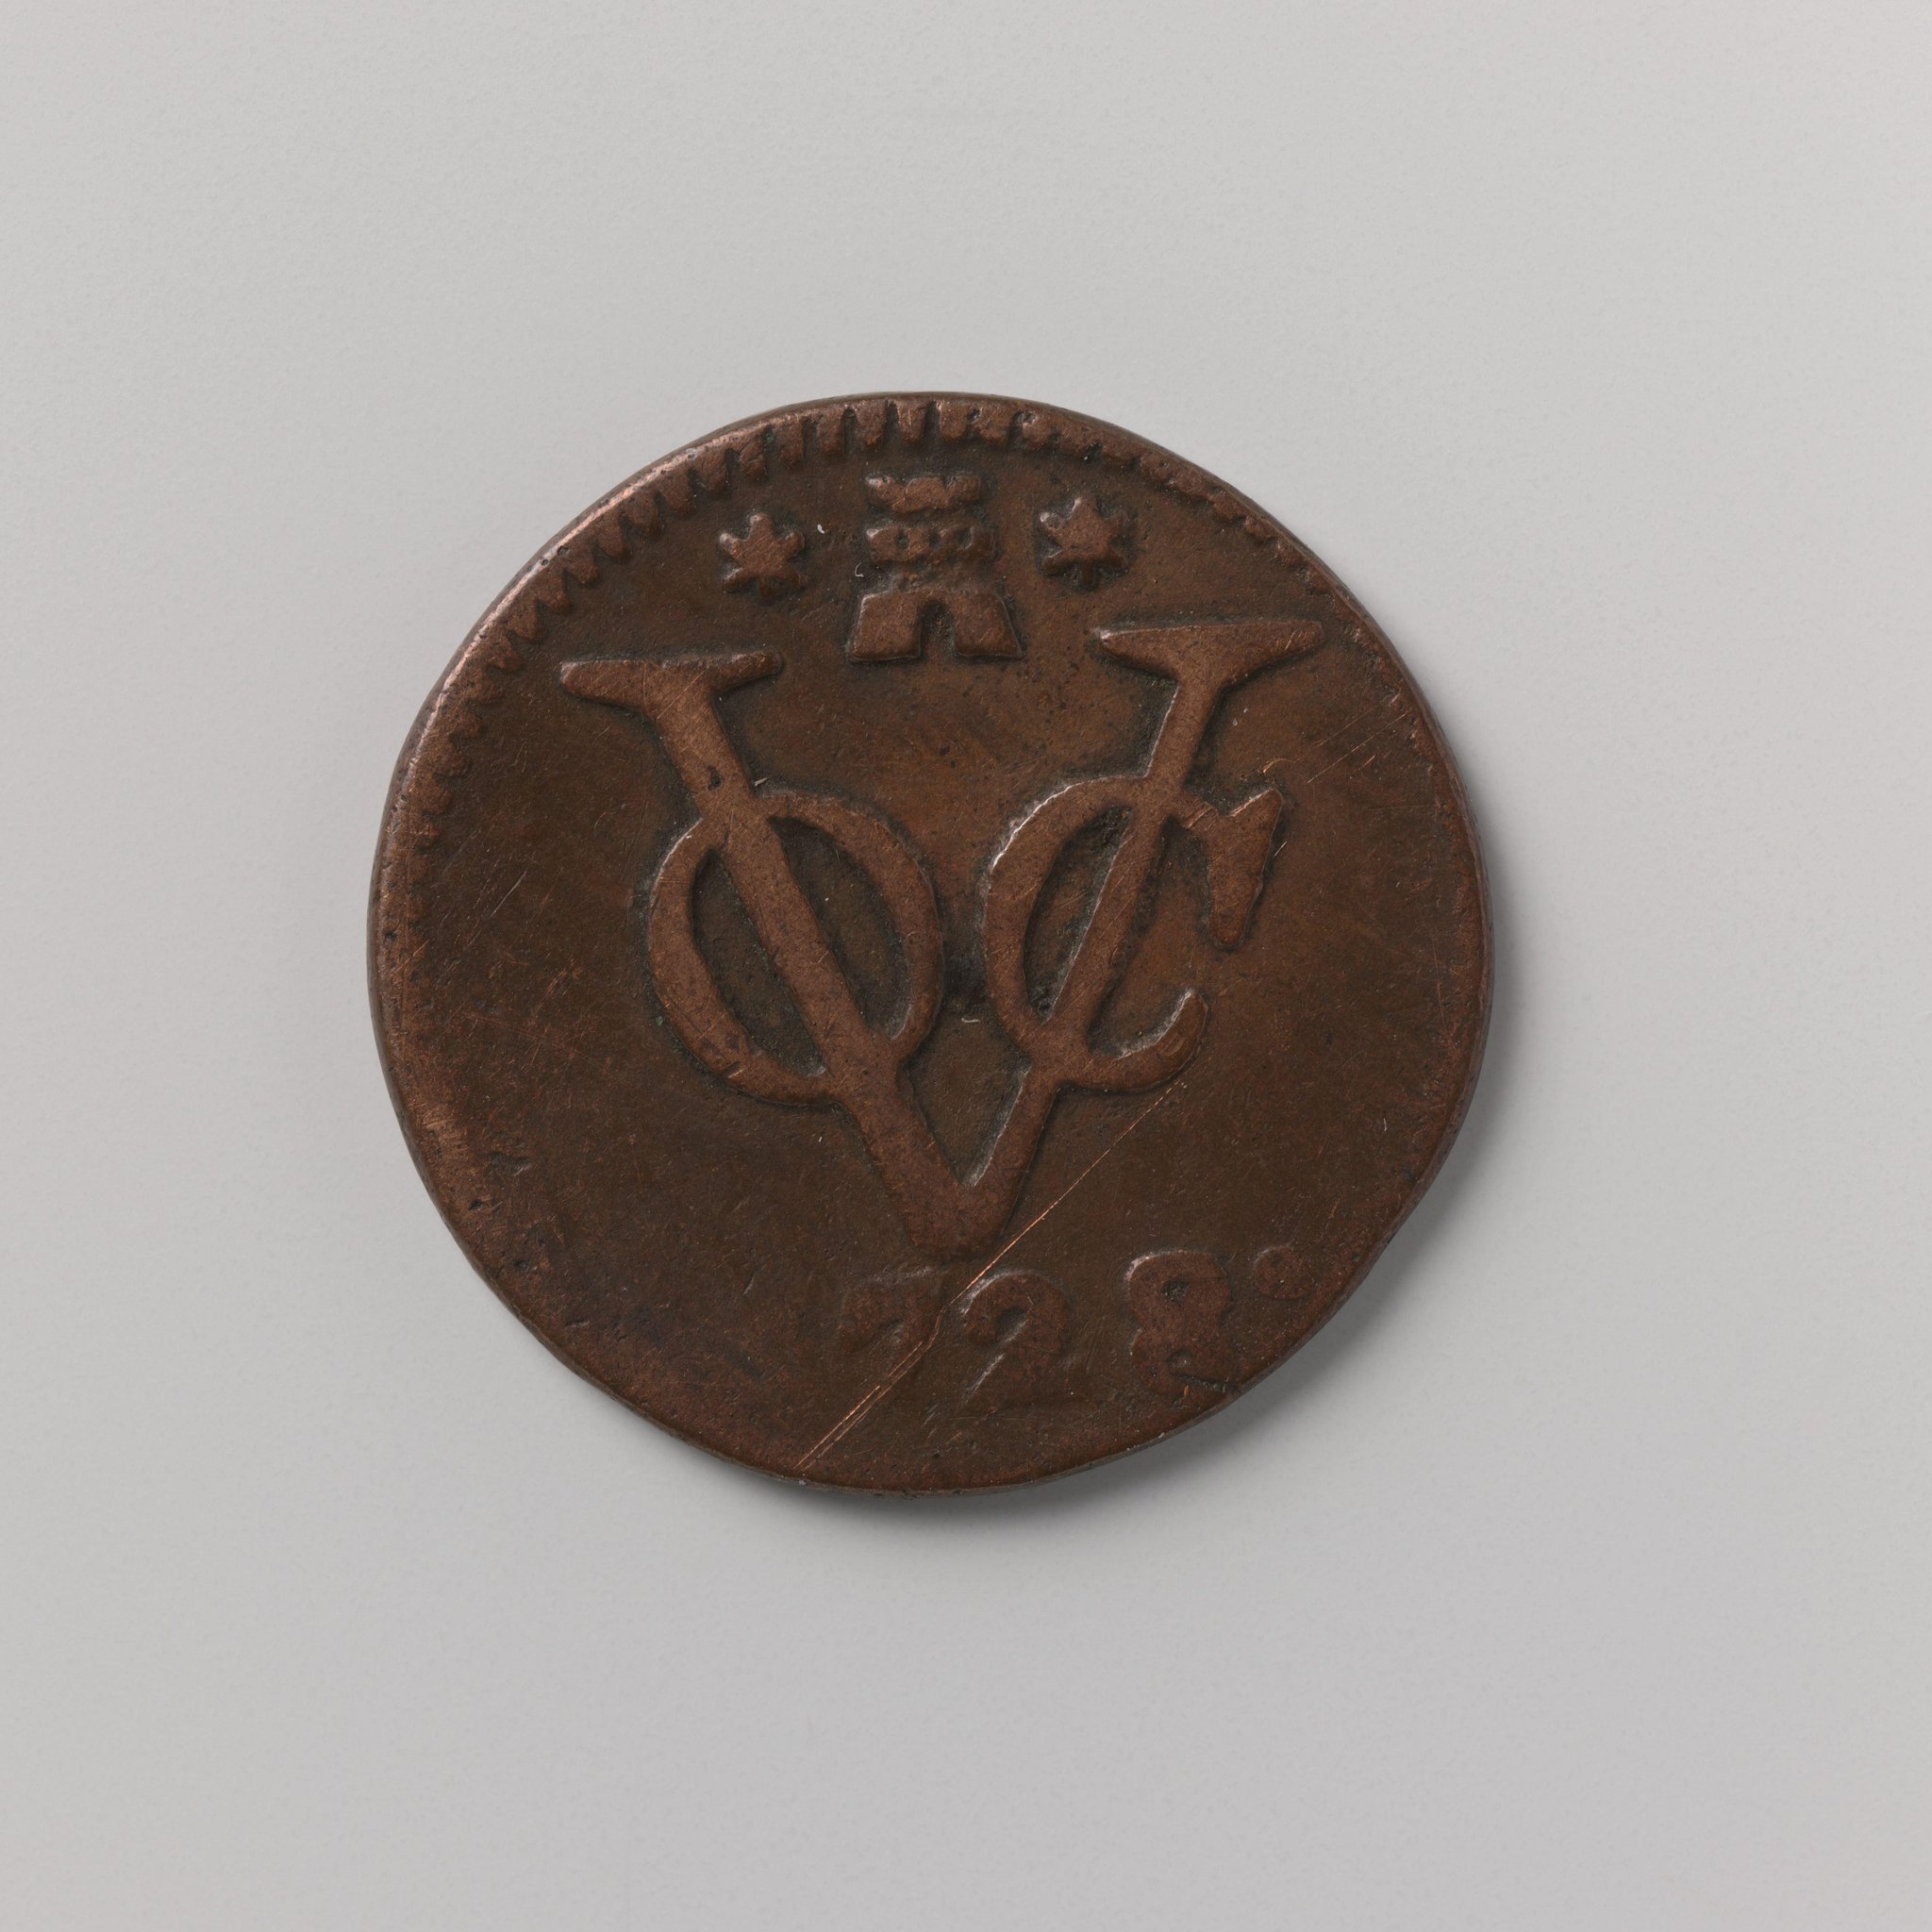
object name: coin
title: VOC, duit Zeeland, 1728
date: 1728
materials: copper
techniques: striking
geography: middelburg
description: Koperen munt. Voorzijde: gekroond ingebogen wapenschild van Zeeland en omschrift. Keerzijde: monogram van de VOC, waarboven muntteken en waaronder jaartal. Gladde rand.